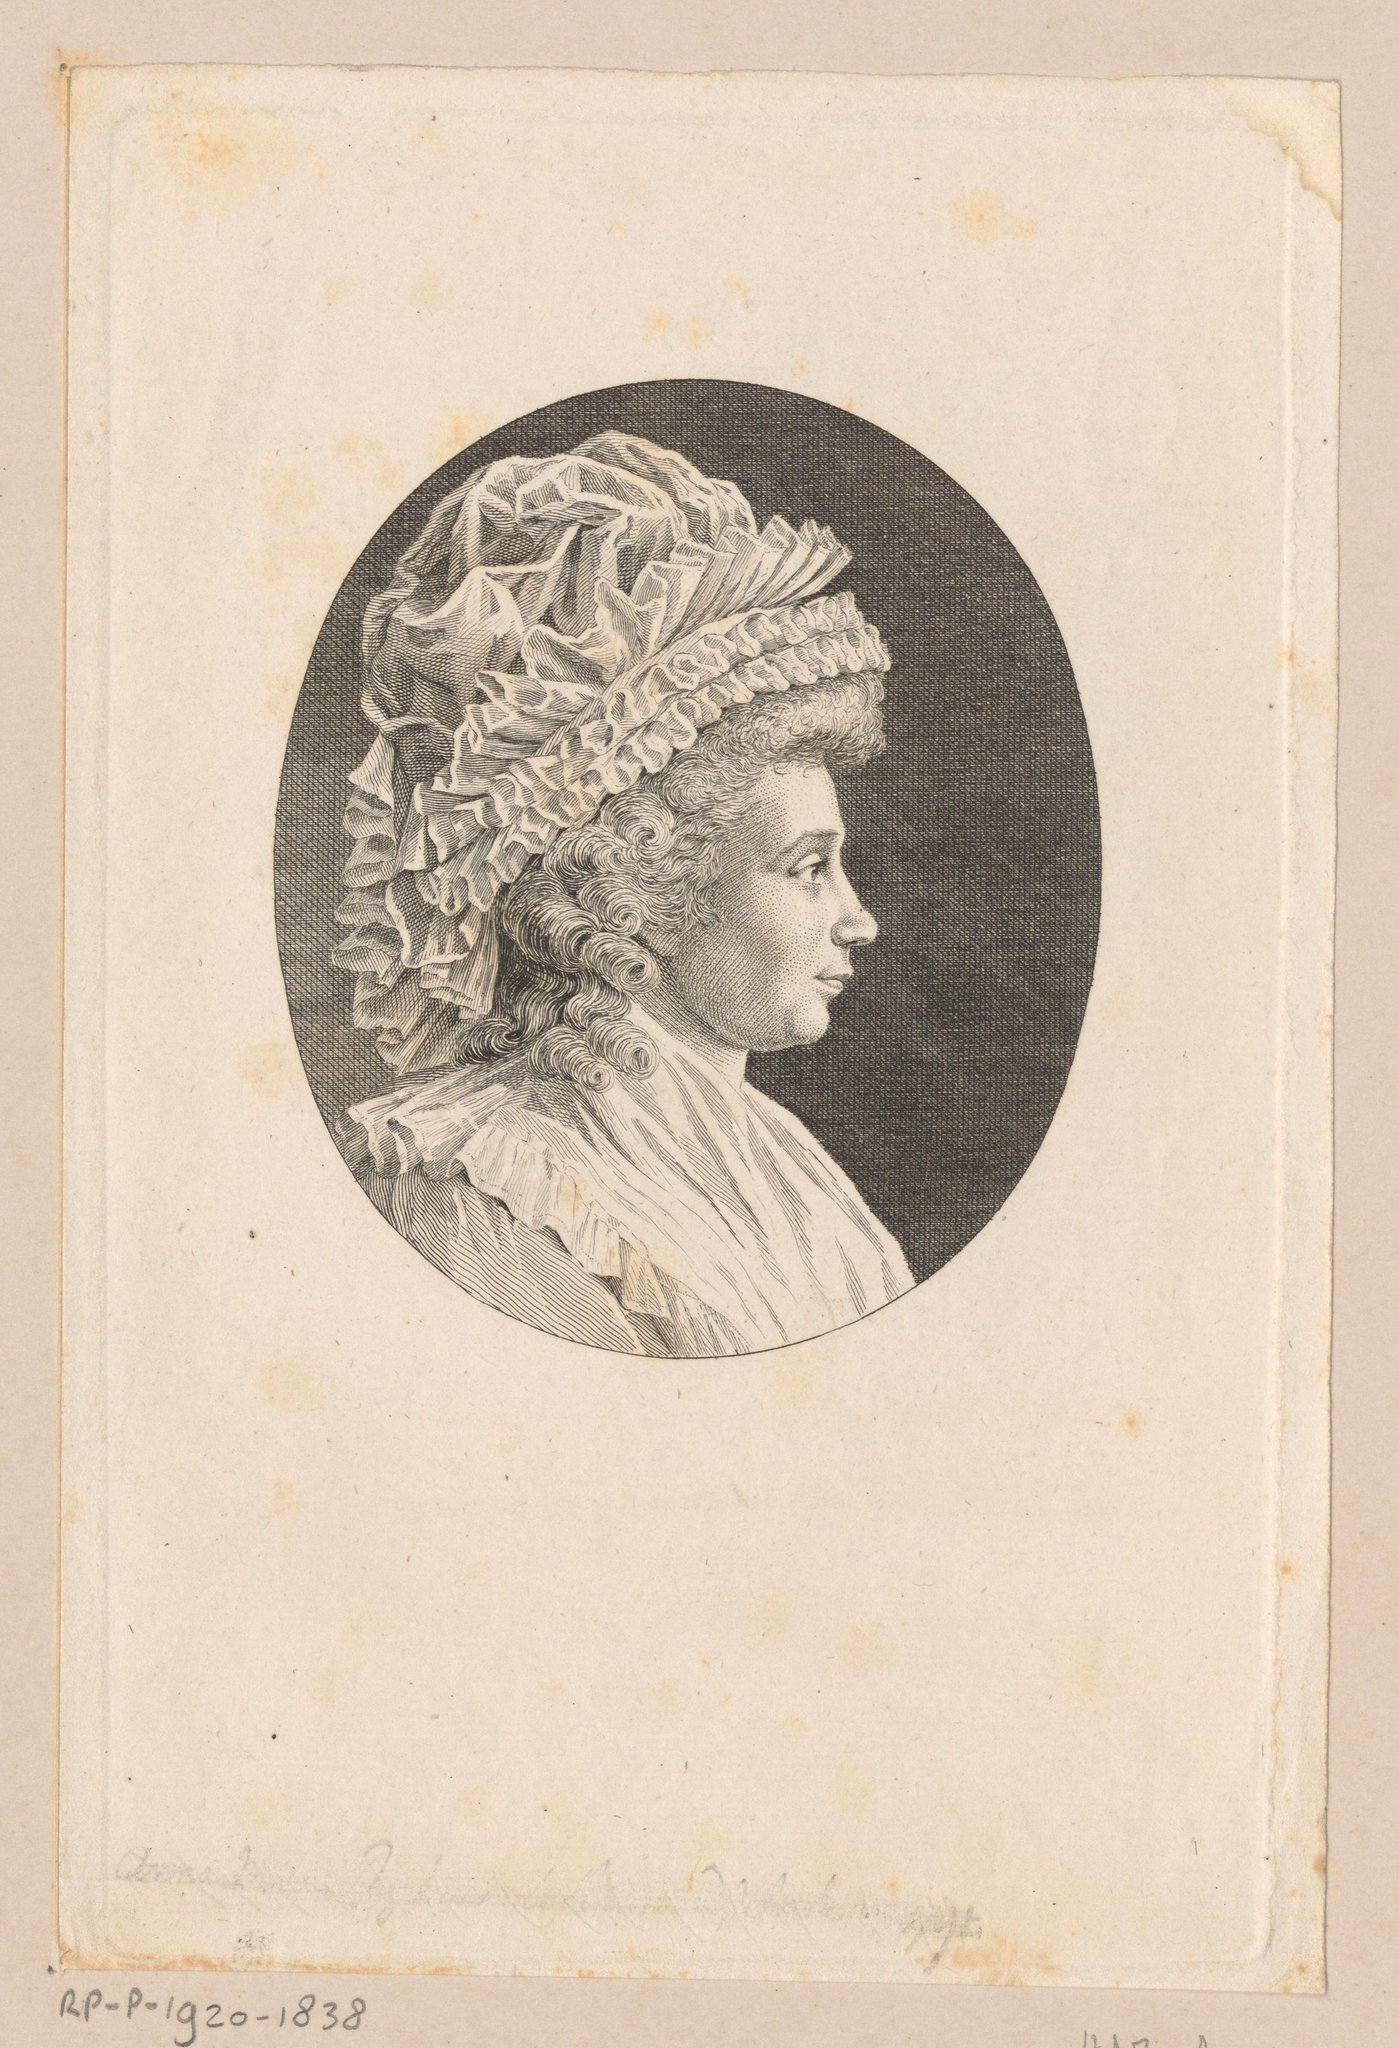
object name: print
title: Portret van Gertrude Sarasin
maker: Anonymous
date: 1791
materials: paper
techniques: engraving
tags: historical persons - bb - woman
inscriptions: collector's mark: Lugt 2228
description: Prent waarschijnlijk uit: Bridei, Philippe. Service funèbre pour la sépulture de Madame Gertrude Sarasin née Battier (...). Basel: zoon Willem Haas, 1791.